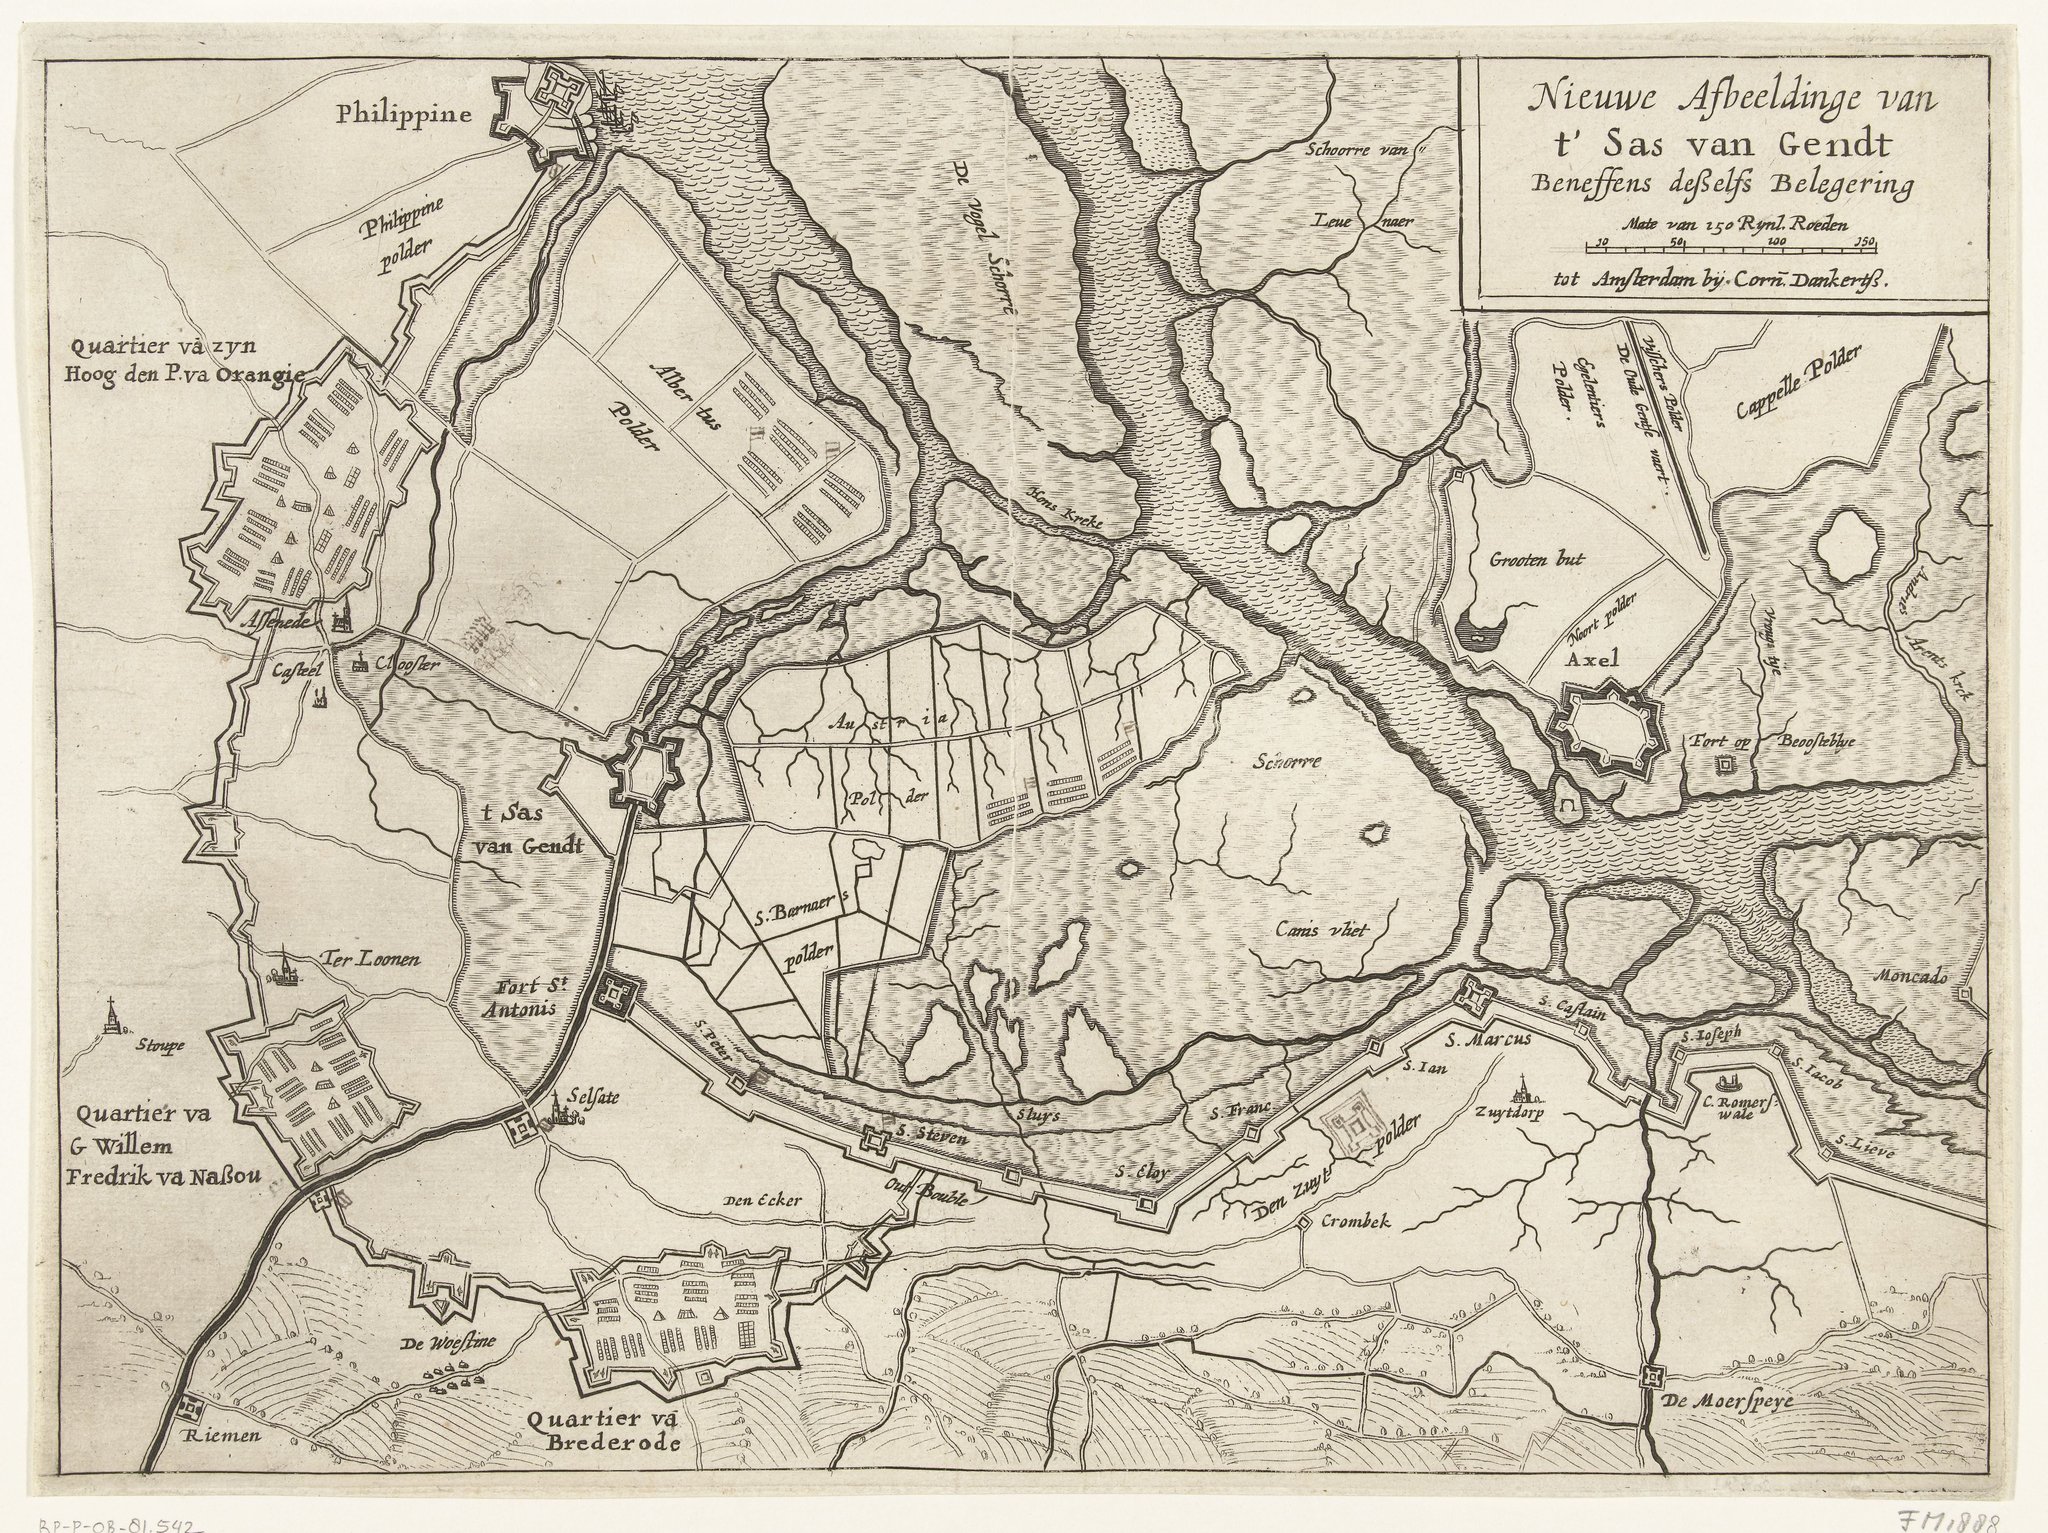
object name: map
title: Kaart van beleg en verovering van Sas-van-Gent, 1644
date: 1644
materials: paper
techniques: engraving, etching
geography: amsterdam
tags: delft, the hague, frederick henry (prince of orange), maps of separate countries or regions, siege, position war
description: Kaart van het beleg van de stad Sas-van Gent door het Staatse leger onder Frederik Hendrik, begonnen 28 juli en ingenomen op 5 september 1644. Kaart van Sas-van-Gent en het omliggende land met de dijken en schansen aangelegd door de belegeraars en hun legerkampen.